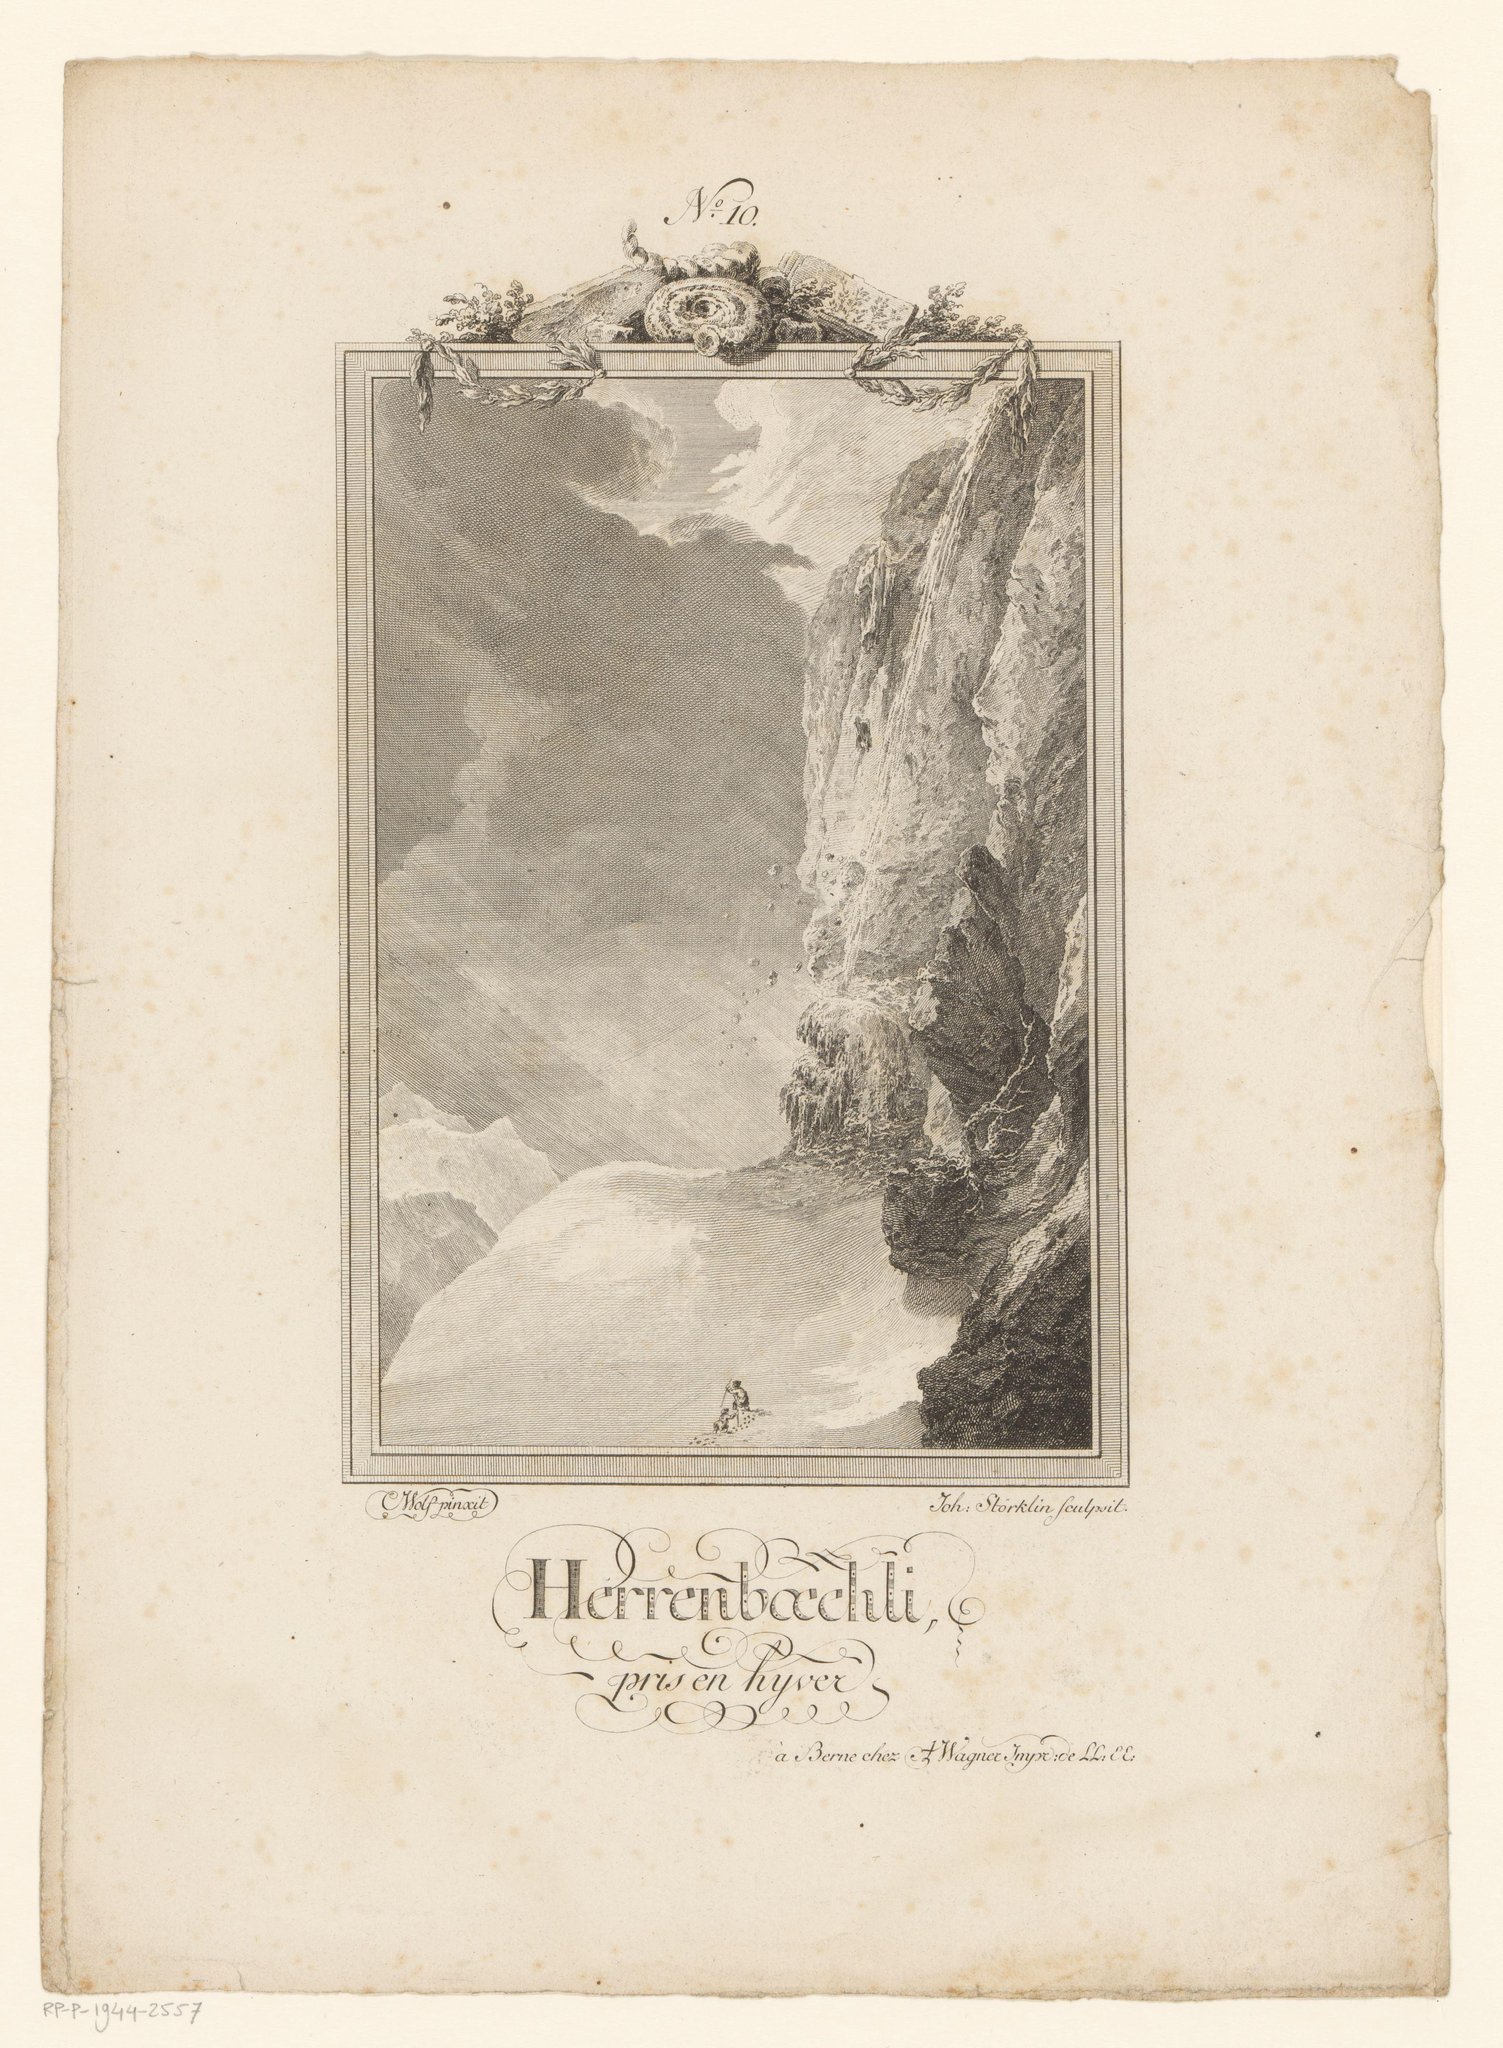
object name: print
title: Herrenbaechli pris en hyver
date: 1745-1778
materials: paper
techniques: etching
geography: bern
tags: snow, mountains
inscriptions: collector's mark: Lugt 2228